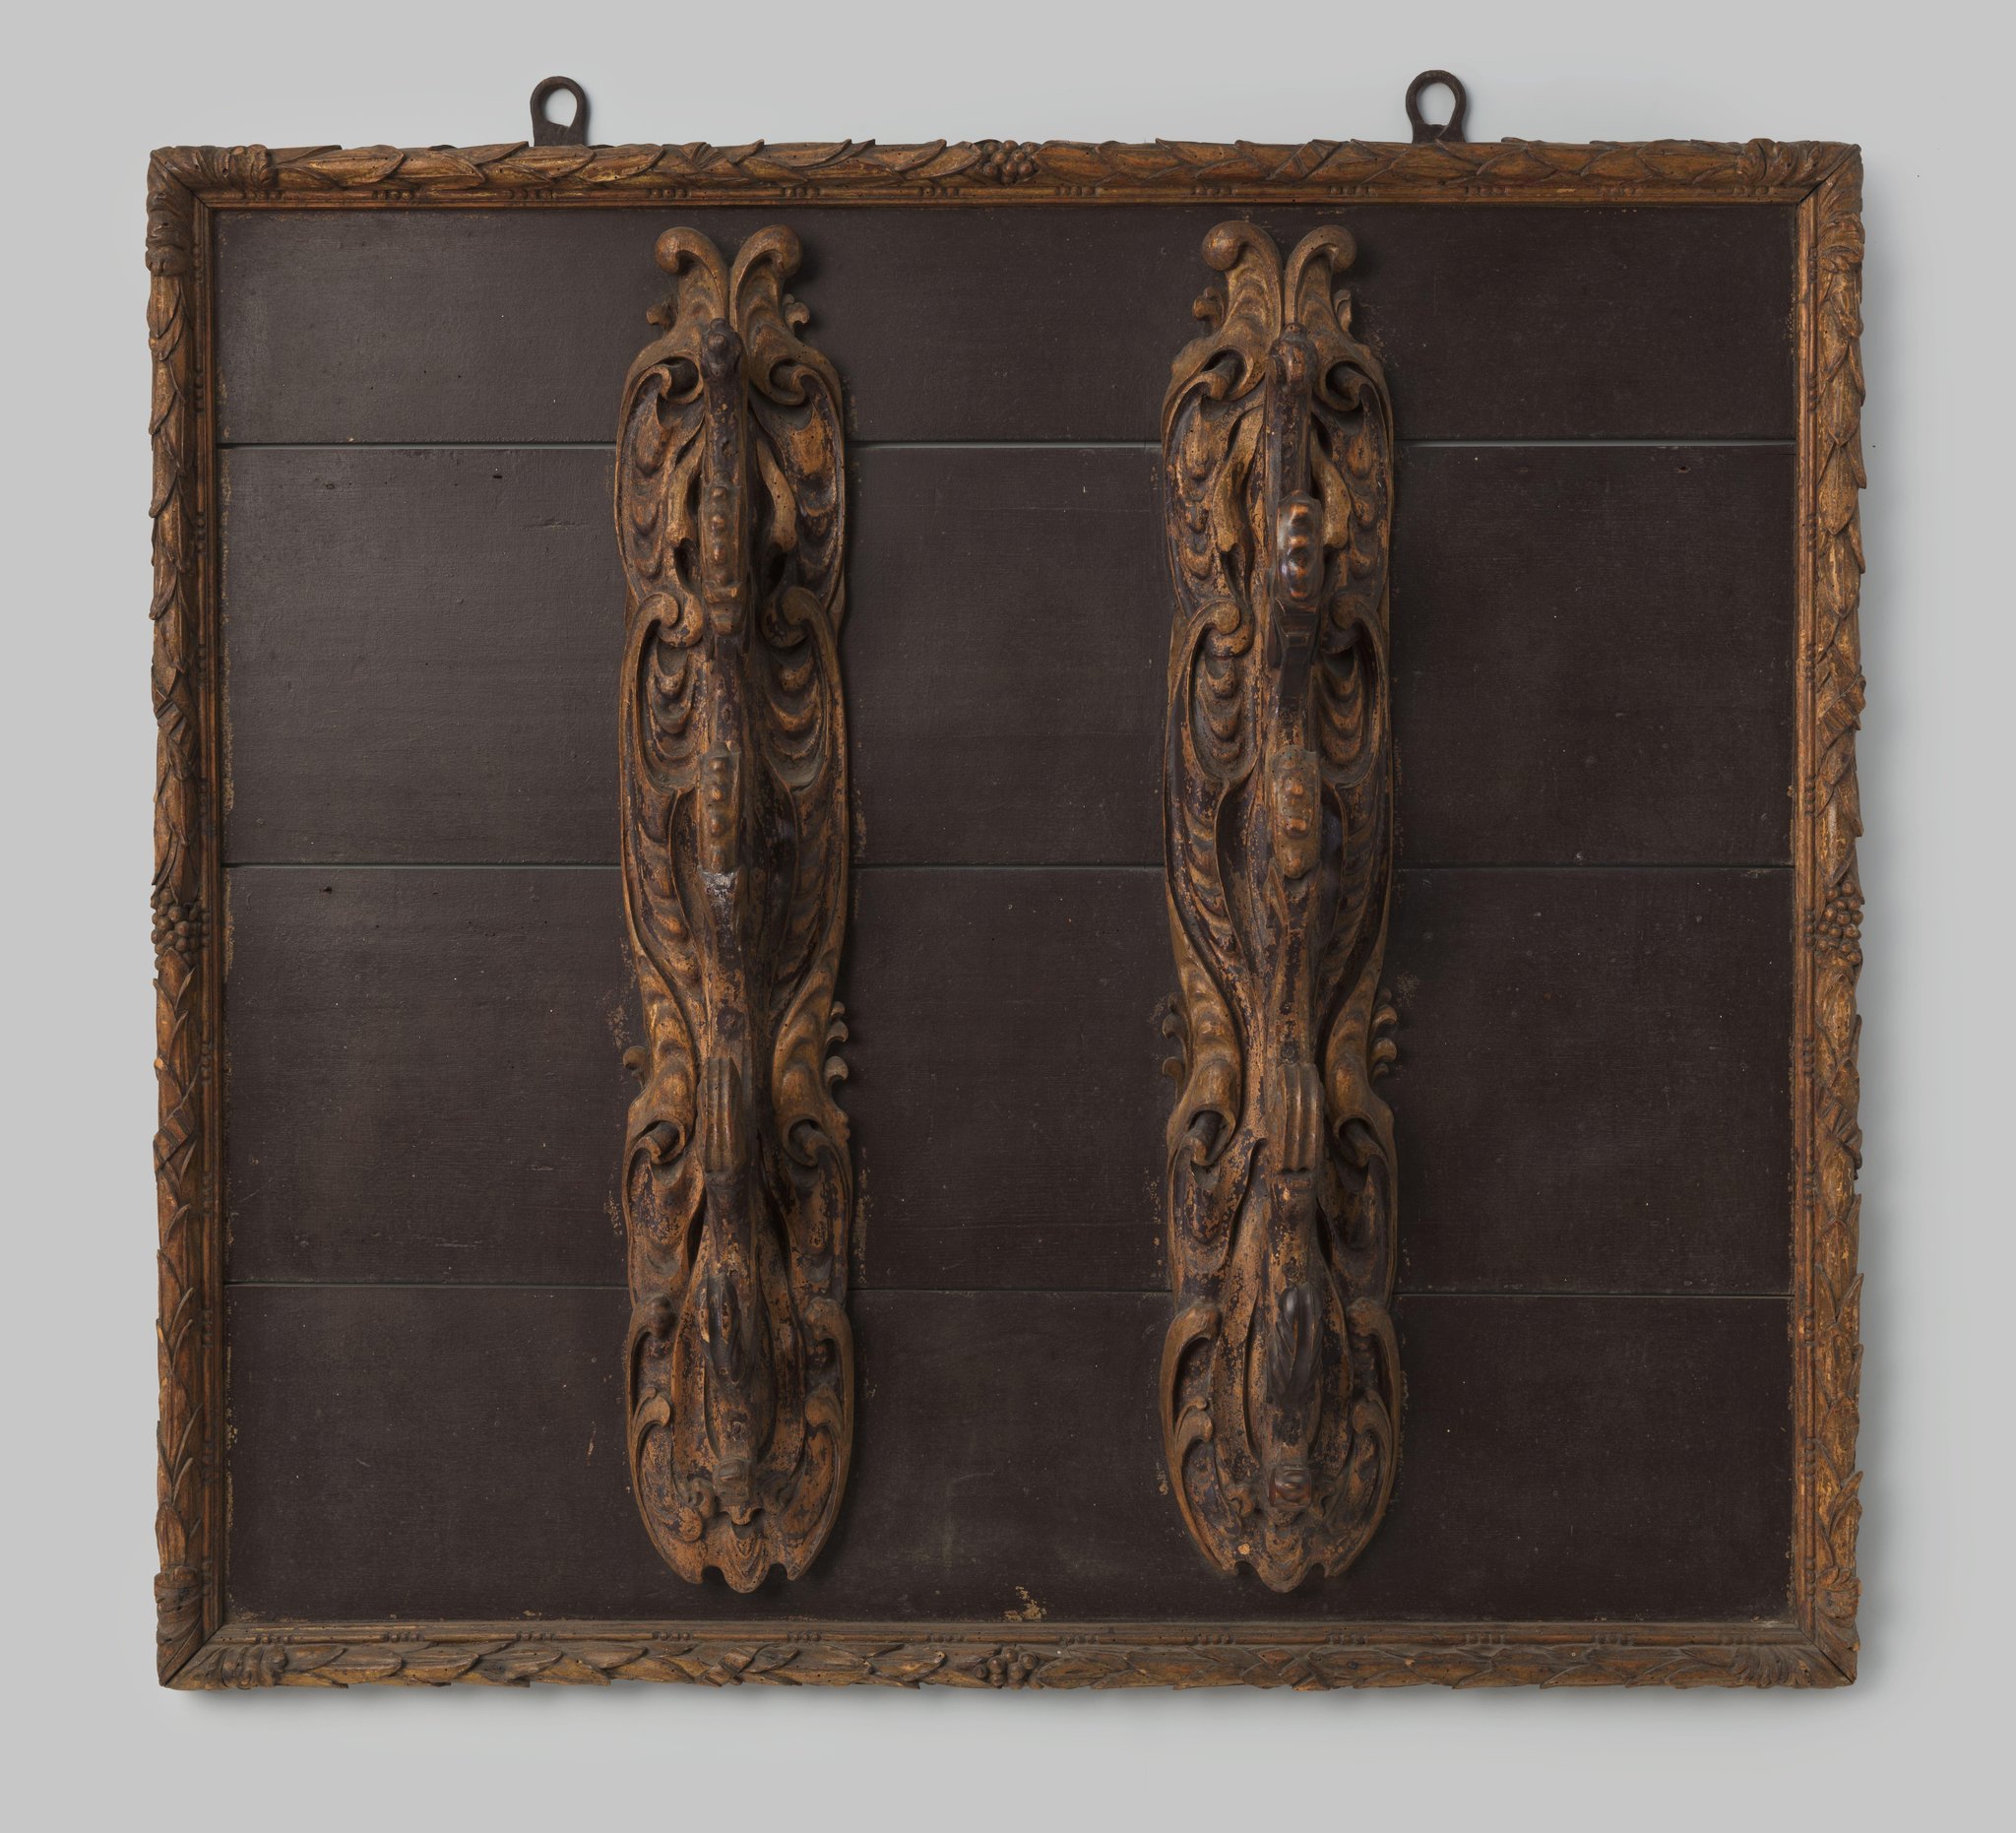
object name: rack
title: Gewerenrek met gestoken versiering in Lodewijk XVIe stijl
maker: Anonymous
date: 1650-1700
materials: wood, paint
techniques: gilding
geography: northern netherlands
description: Gewerenrek van notenhout, gevormd door twee met kwabornament gebeeldhouwde verticale stijlen, waarop boven elkaar vier voluten, ter plaatsing van de geweren, haaks zijn aangebracht. De stijlen zijn paarsgewijs op achterborden, door gestoken Louis XVI-lijsten omgeven, aangebracht. Het rek vertoont resten van donkerbruine, wellicht later aangebrachte verf.